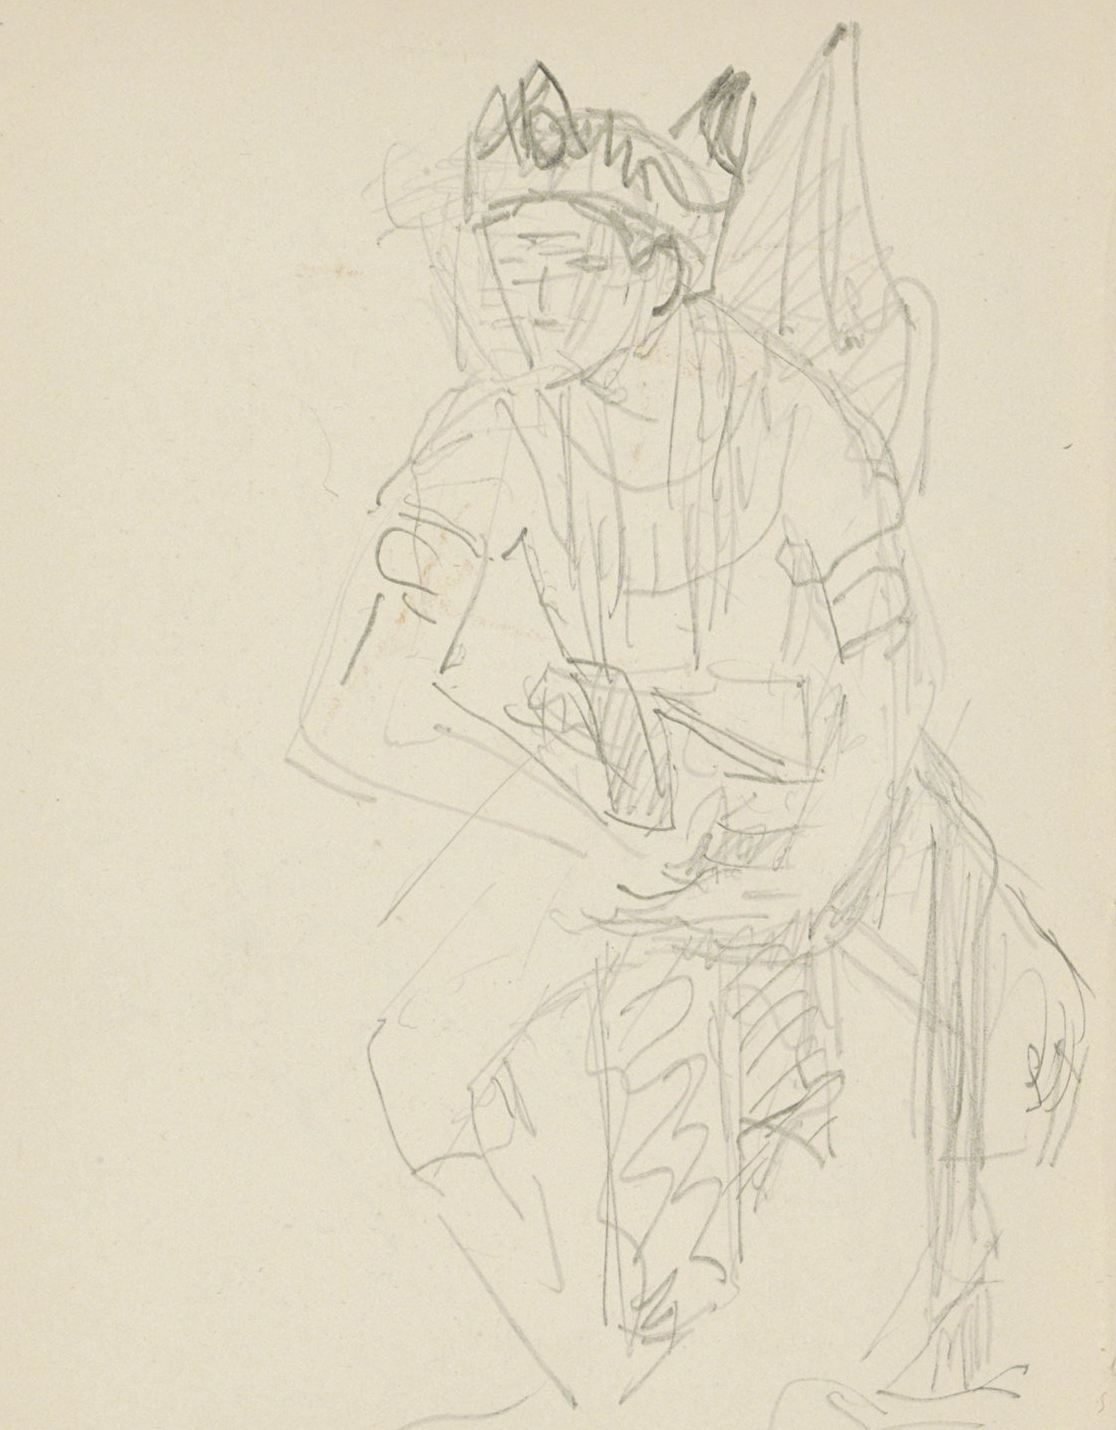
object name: sketchbook leaf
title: Dansende man in traditioneel kostuum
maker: reijer stolk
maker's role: draughtsman, print maker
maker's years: 1896-1945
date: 1906-1945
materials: paper, pencil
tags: folk costume, regional costume, man dancing alone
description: Mogelijk een Javaanse danser. Blad 3 verso uit een schetsboek met 69 bladen.